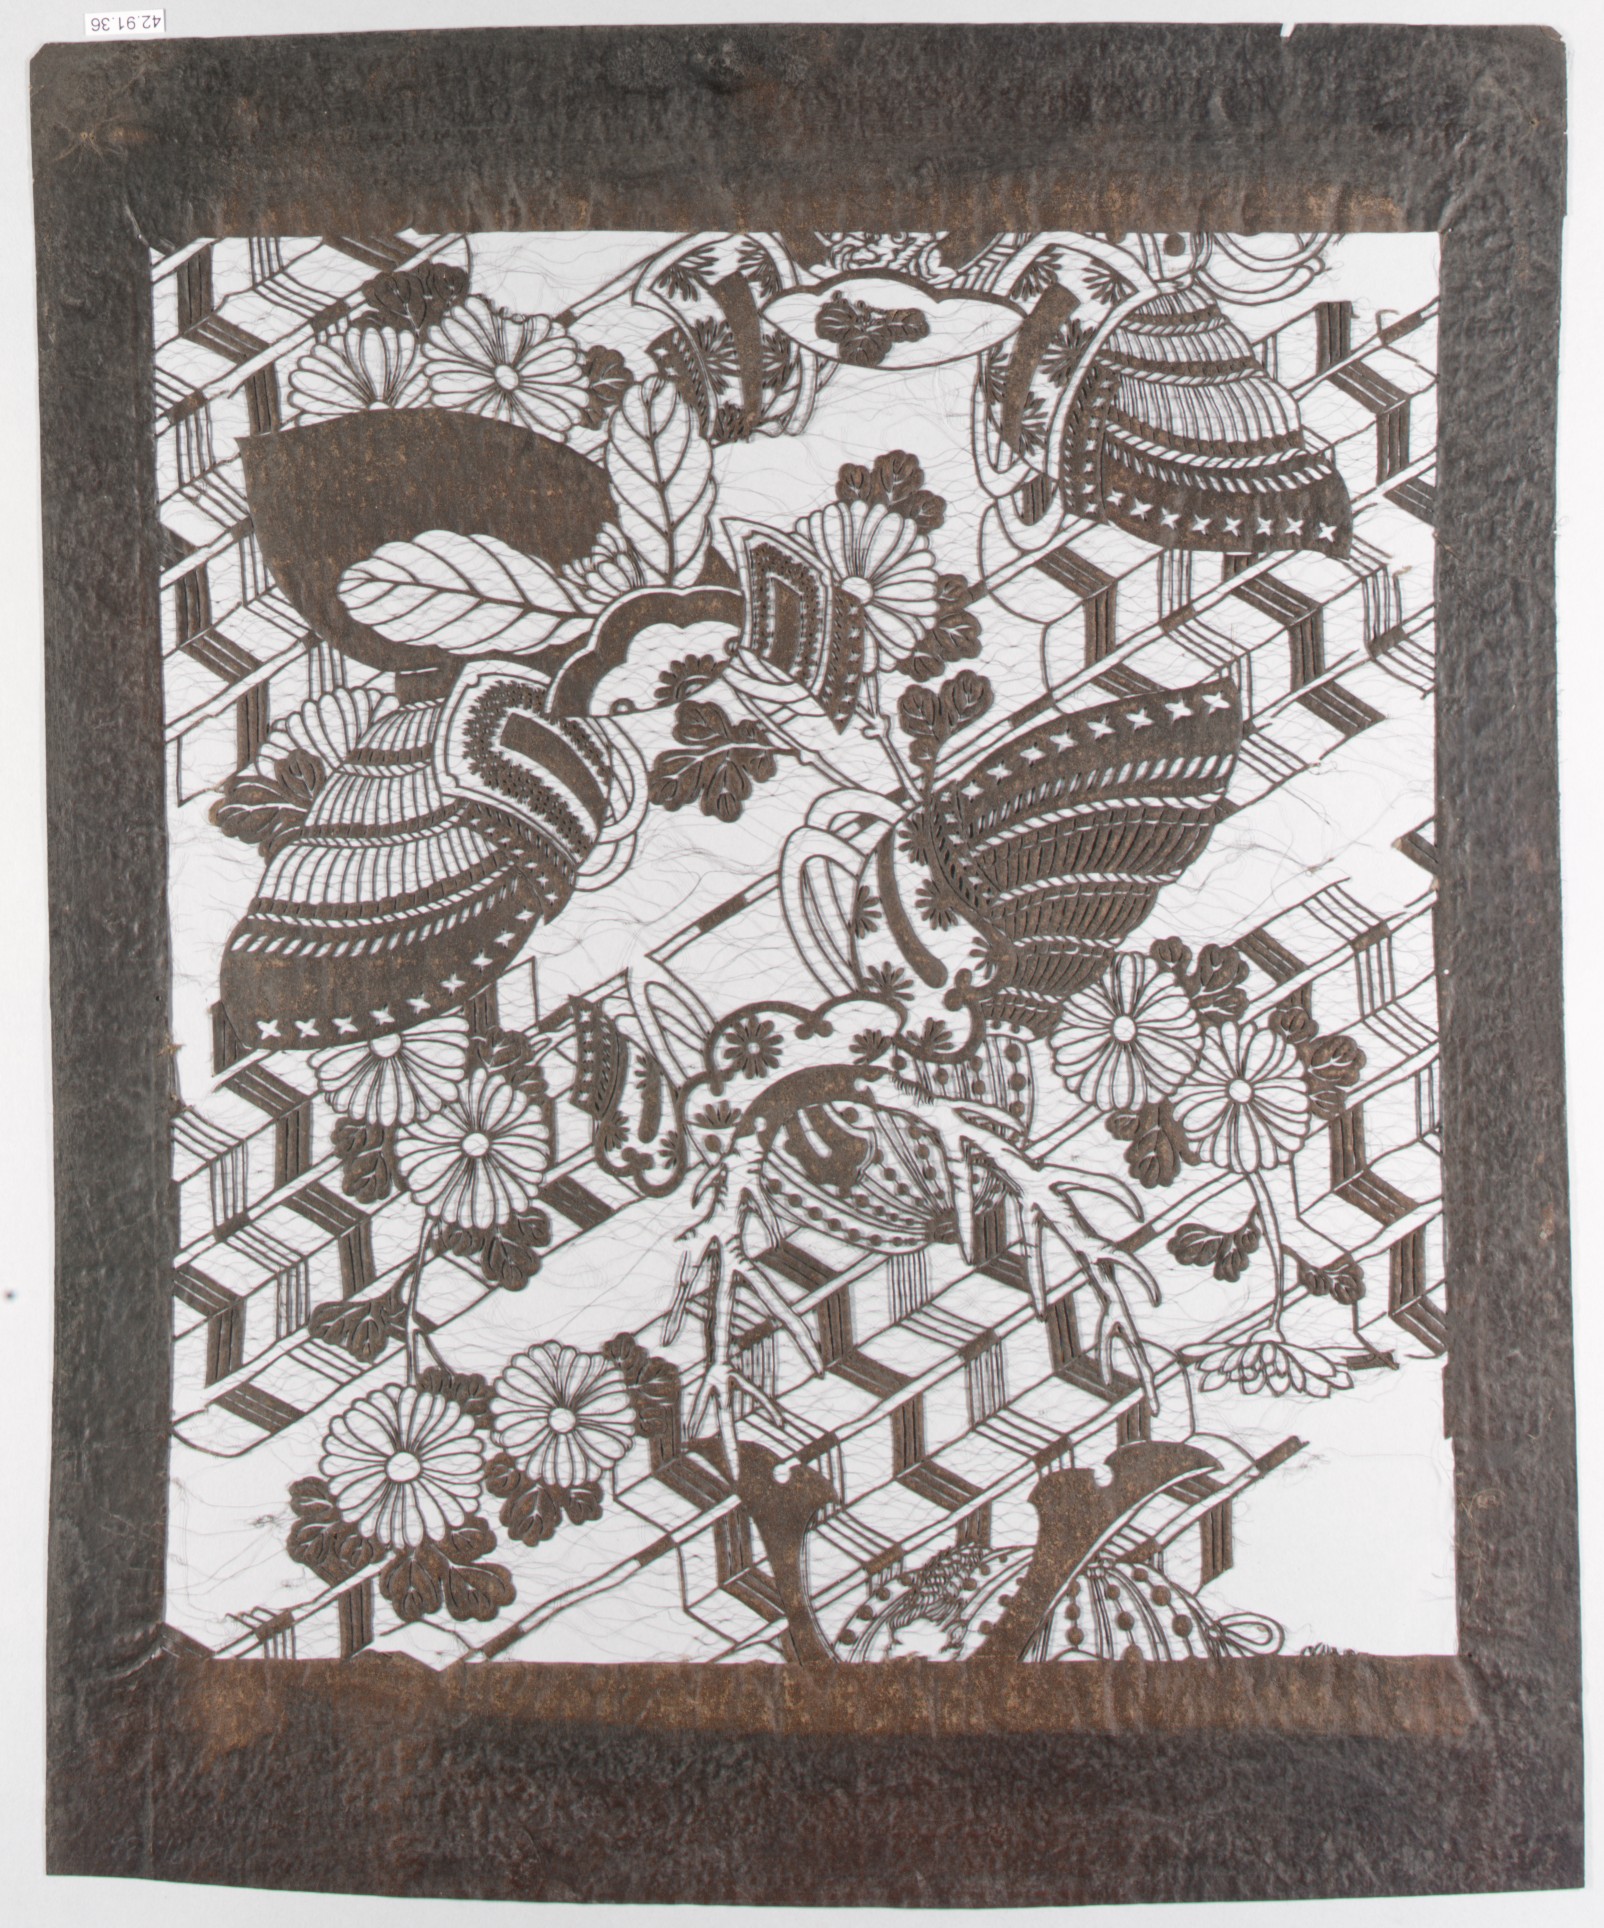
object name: stencil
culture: japanese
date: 1801-1900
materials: paper, silk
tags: helmets,flowers